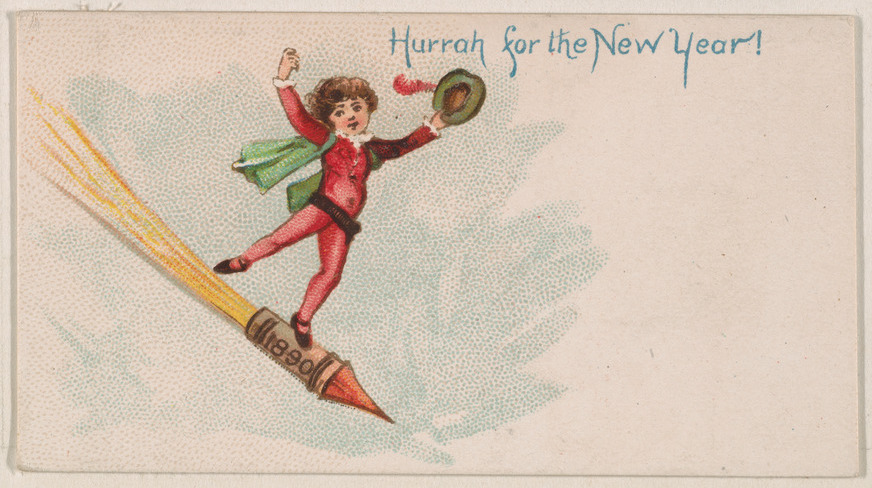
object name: print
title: Hurrah for the New Year, from the New Years 1890 series (N227) issued by Kinney Bros.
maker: kinney brothers tobacco company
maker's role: publisher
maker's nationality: american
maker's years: 1869-2011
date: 1889-1890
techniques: color lithograph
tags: boys